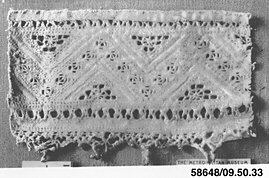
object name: fragment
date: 1801-1900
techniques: lace, embroidery